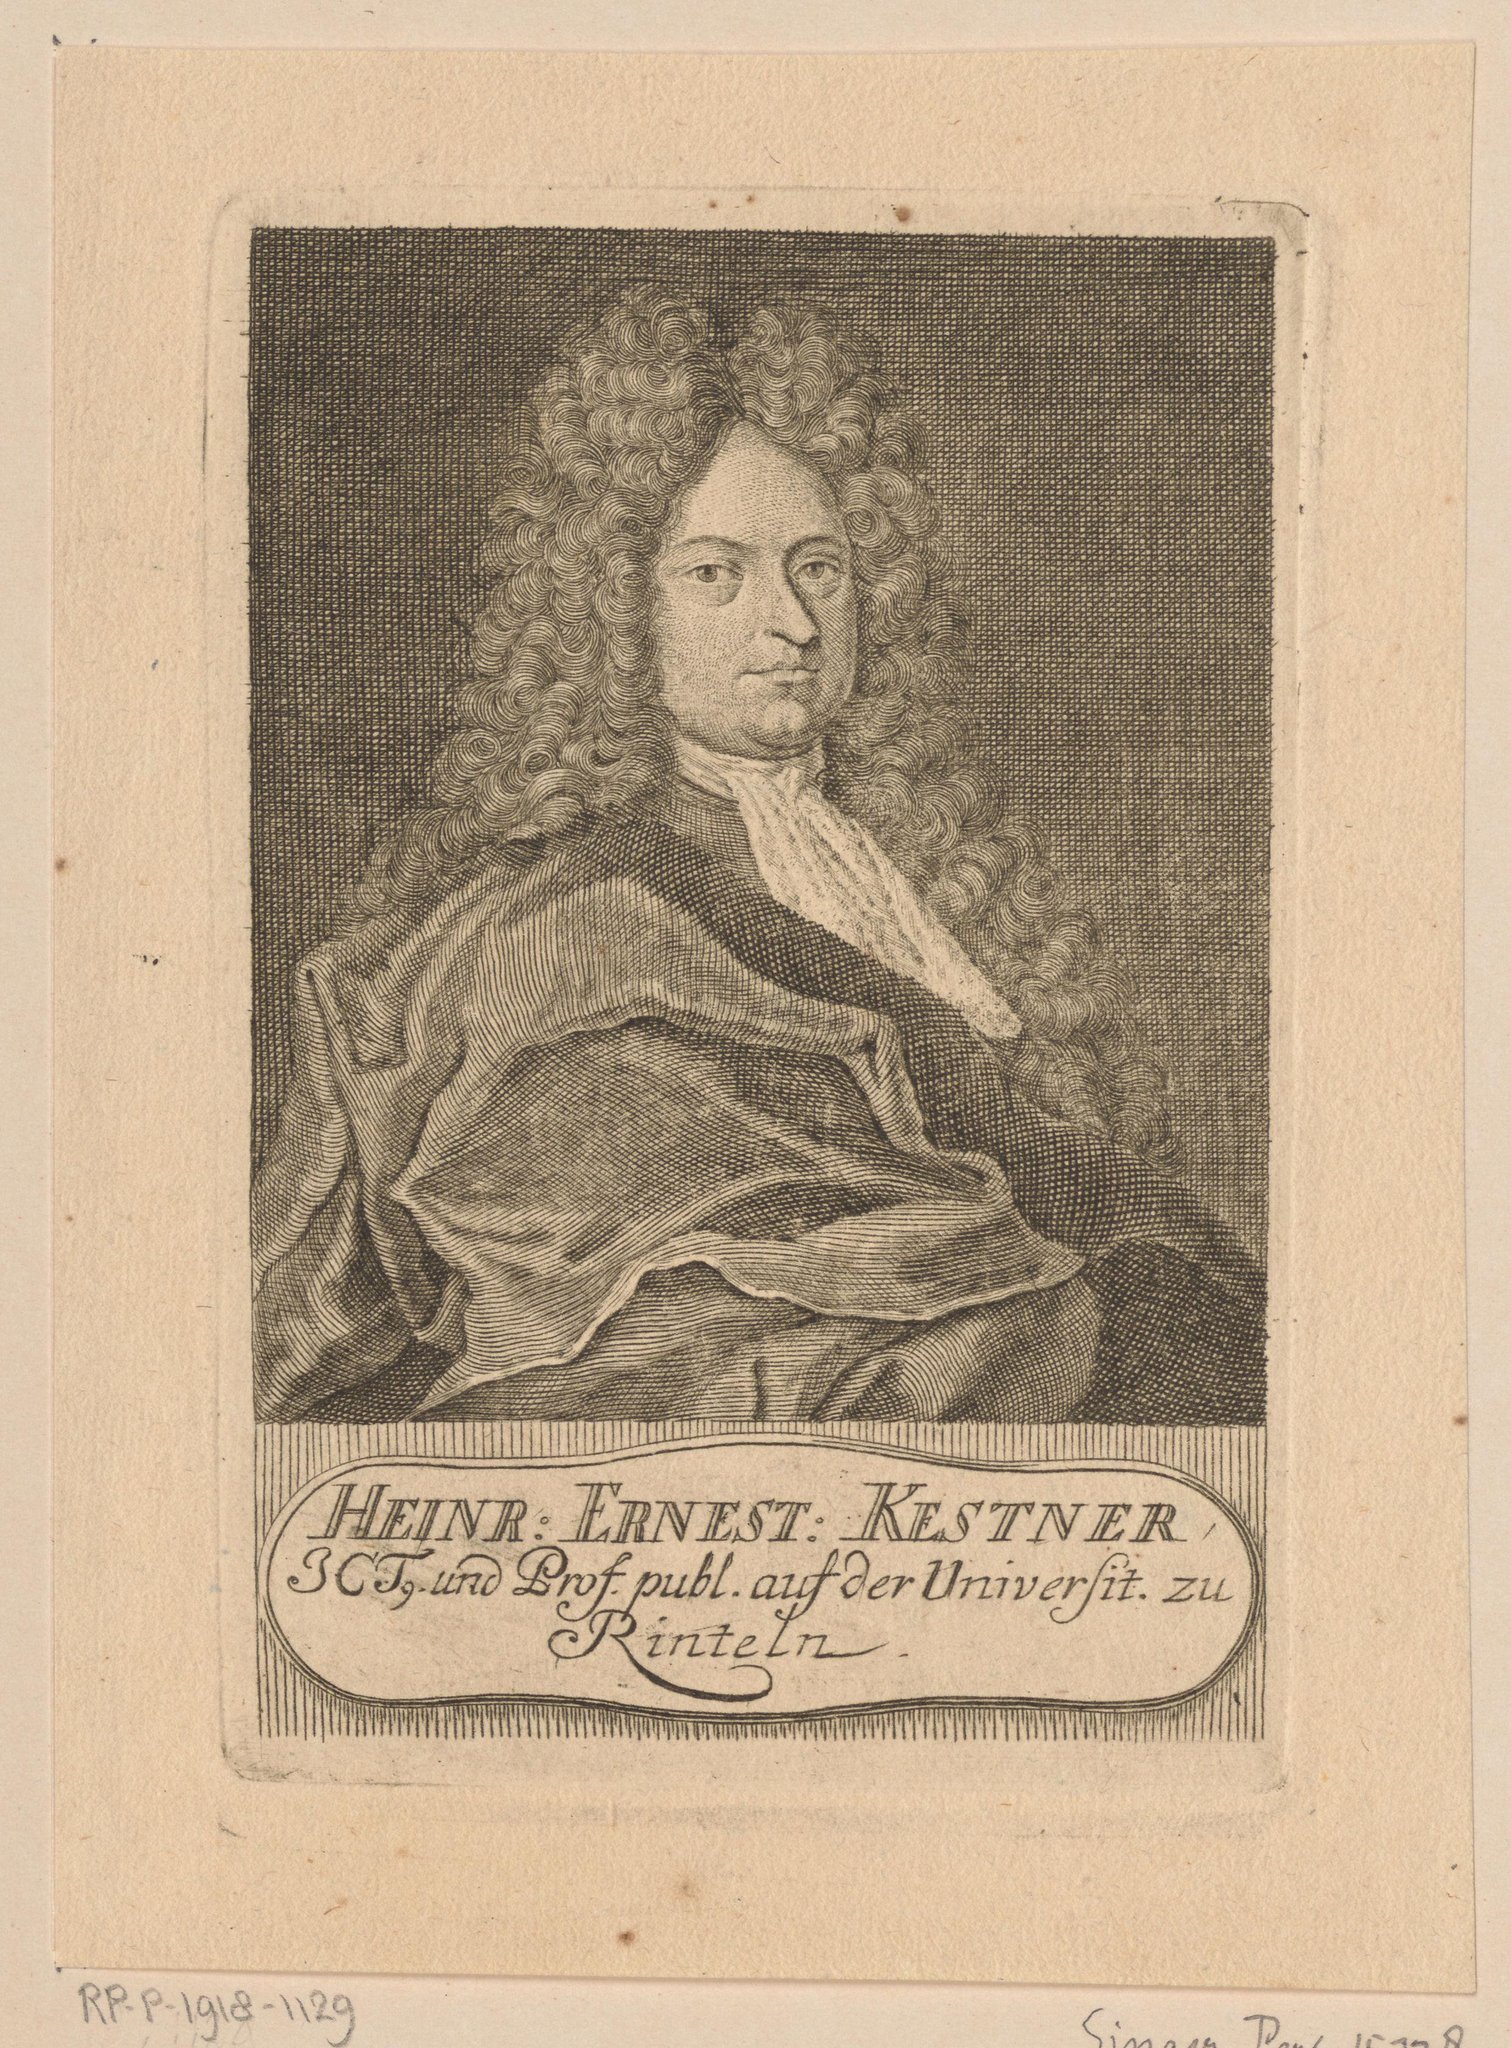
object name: print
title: Portret van Heinrich Ernst Kestner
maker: johann georg mentzel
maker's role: print maker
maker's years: 1677-1743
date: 1696-1743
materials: paper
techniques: engraving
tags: historical persons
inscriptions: collector's mark: Lugt 2233